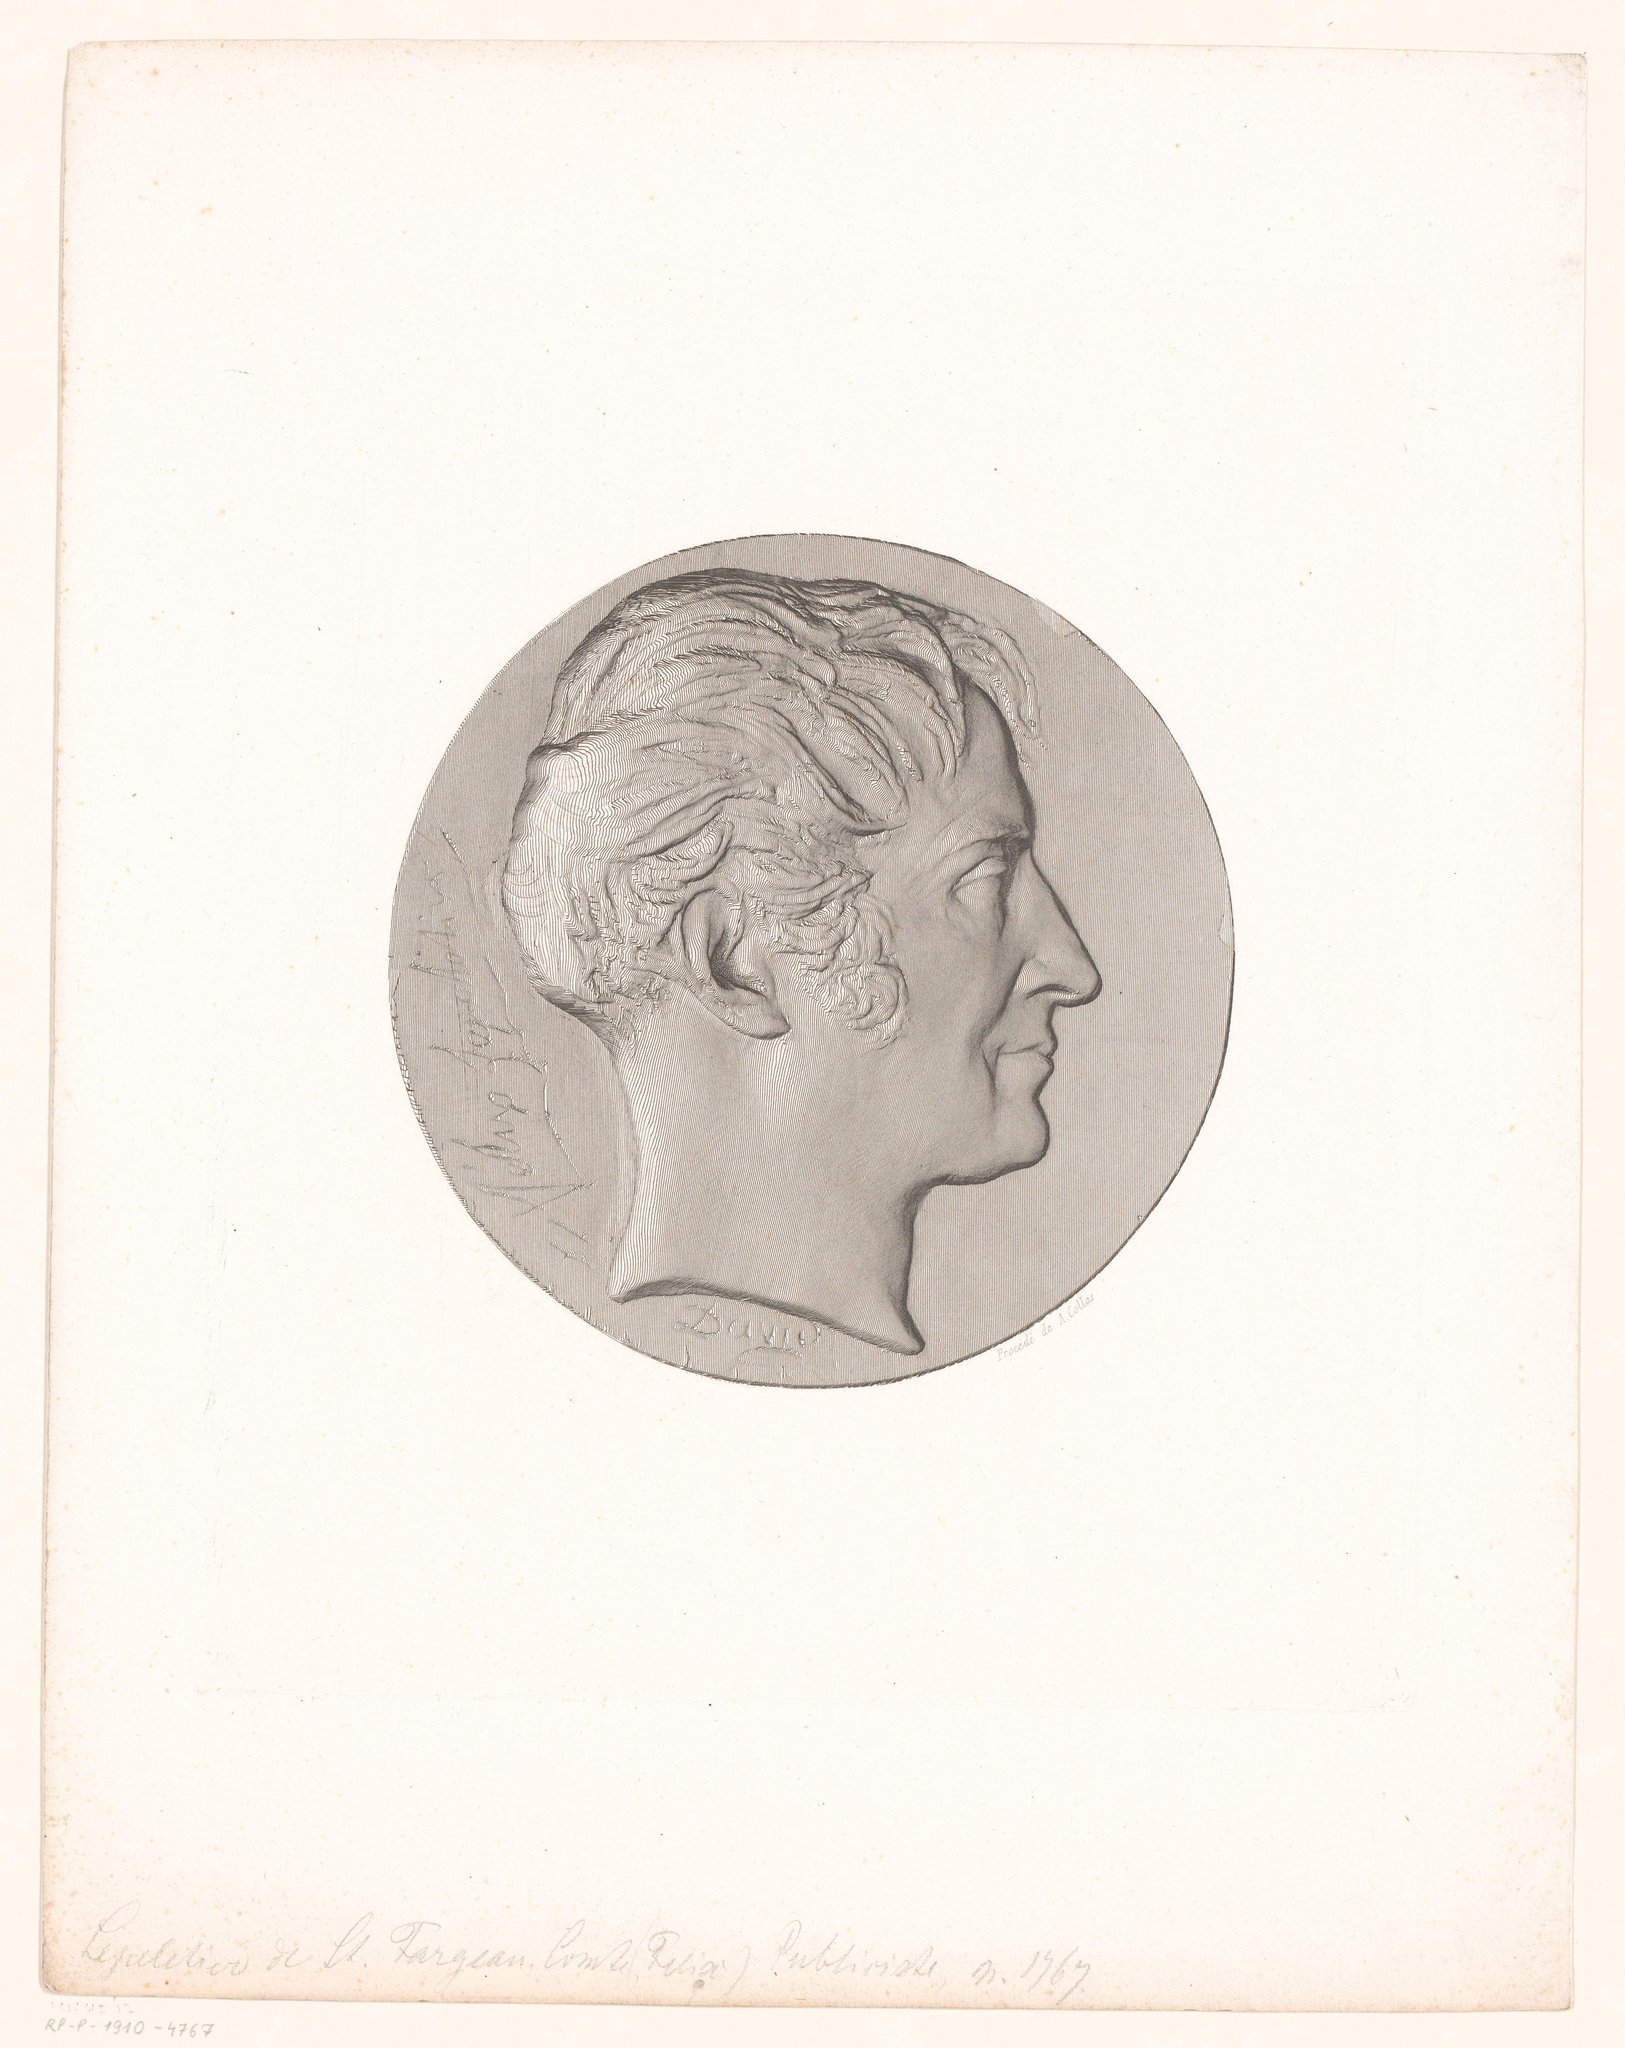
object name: print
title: Félix Lepeletier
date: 1820-1840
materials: paper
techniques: relief engraving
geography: france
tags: paris, ornament ~ medallion, historical persons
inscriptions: collector's mark: Lugt 2228